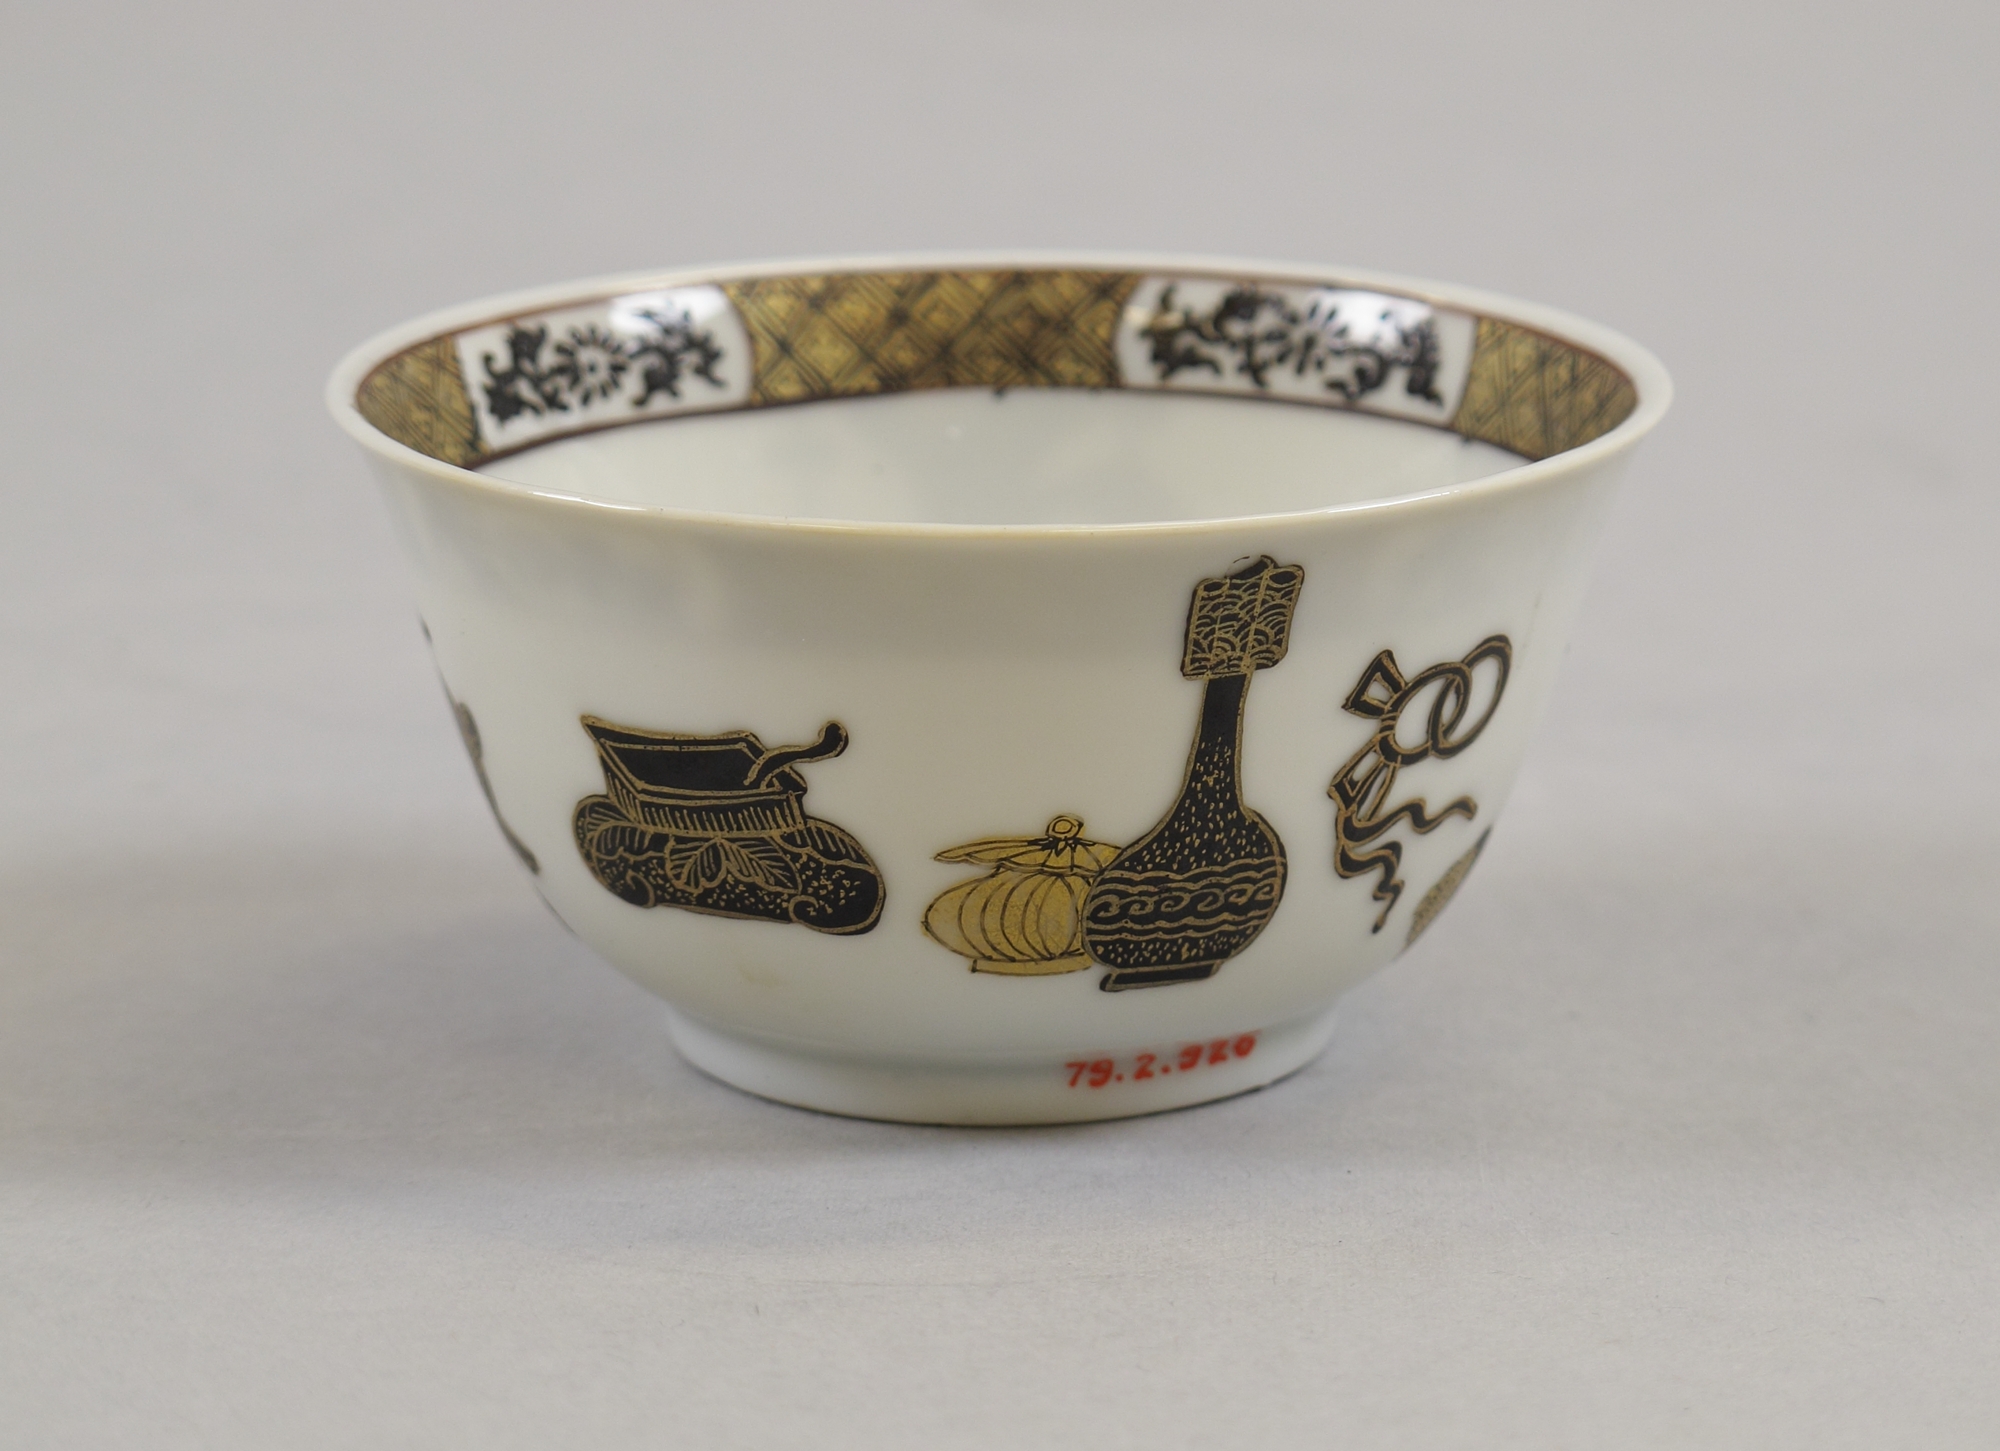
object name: cup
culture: chinese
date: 1736-1795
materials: enamel, gilt, porcelain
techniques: overglaze, painting